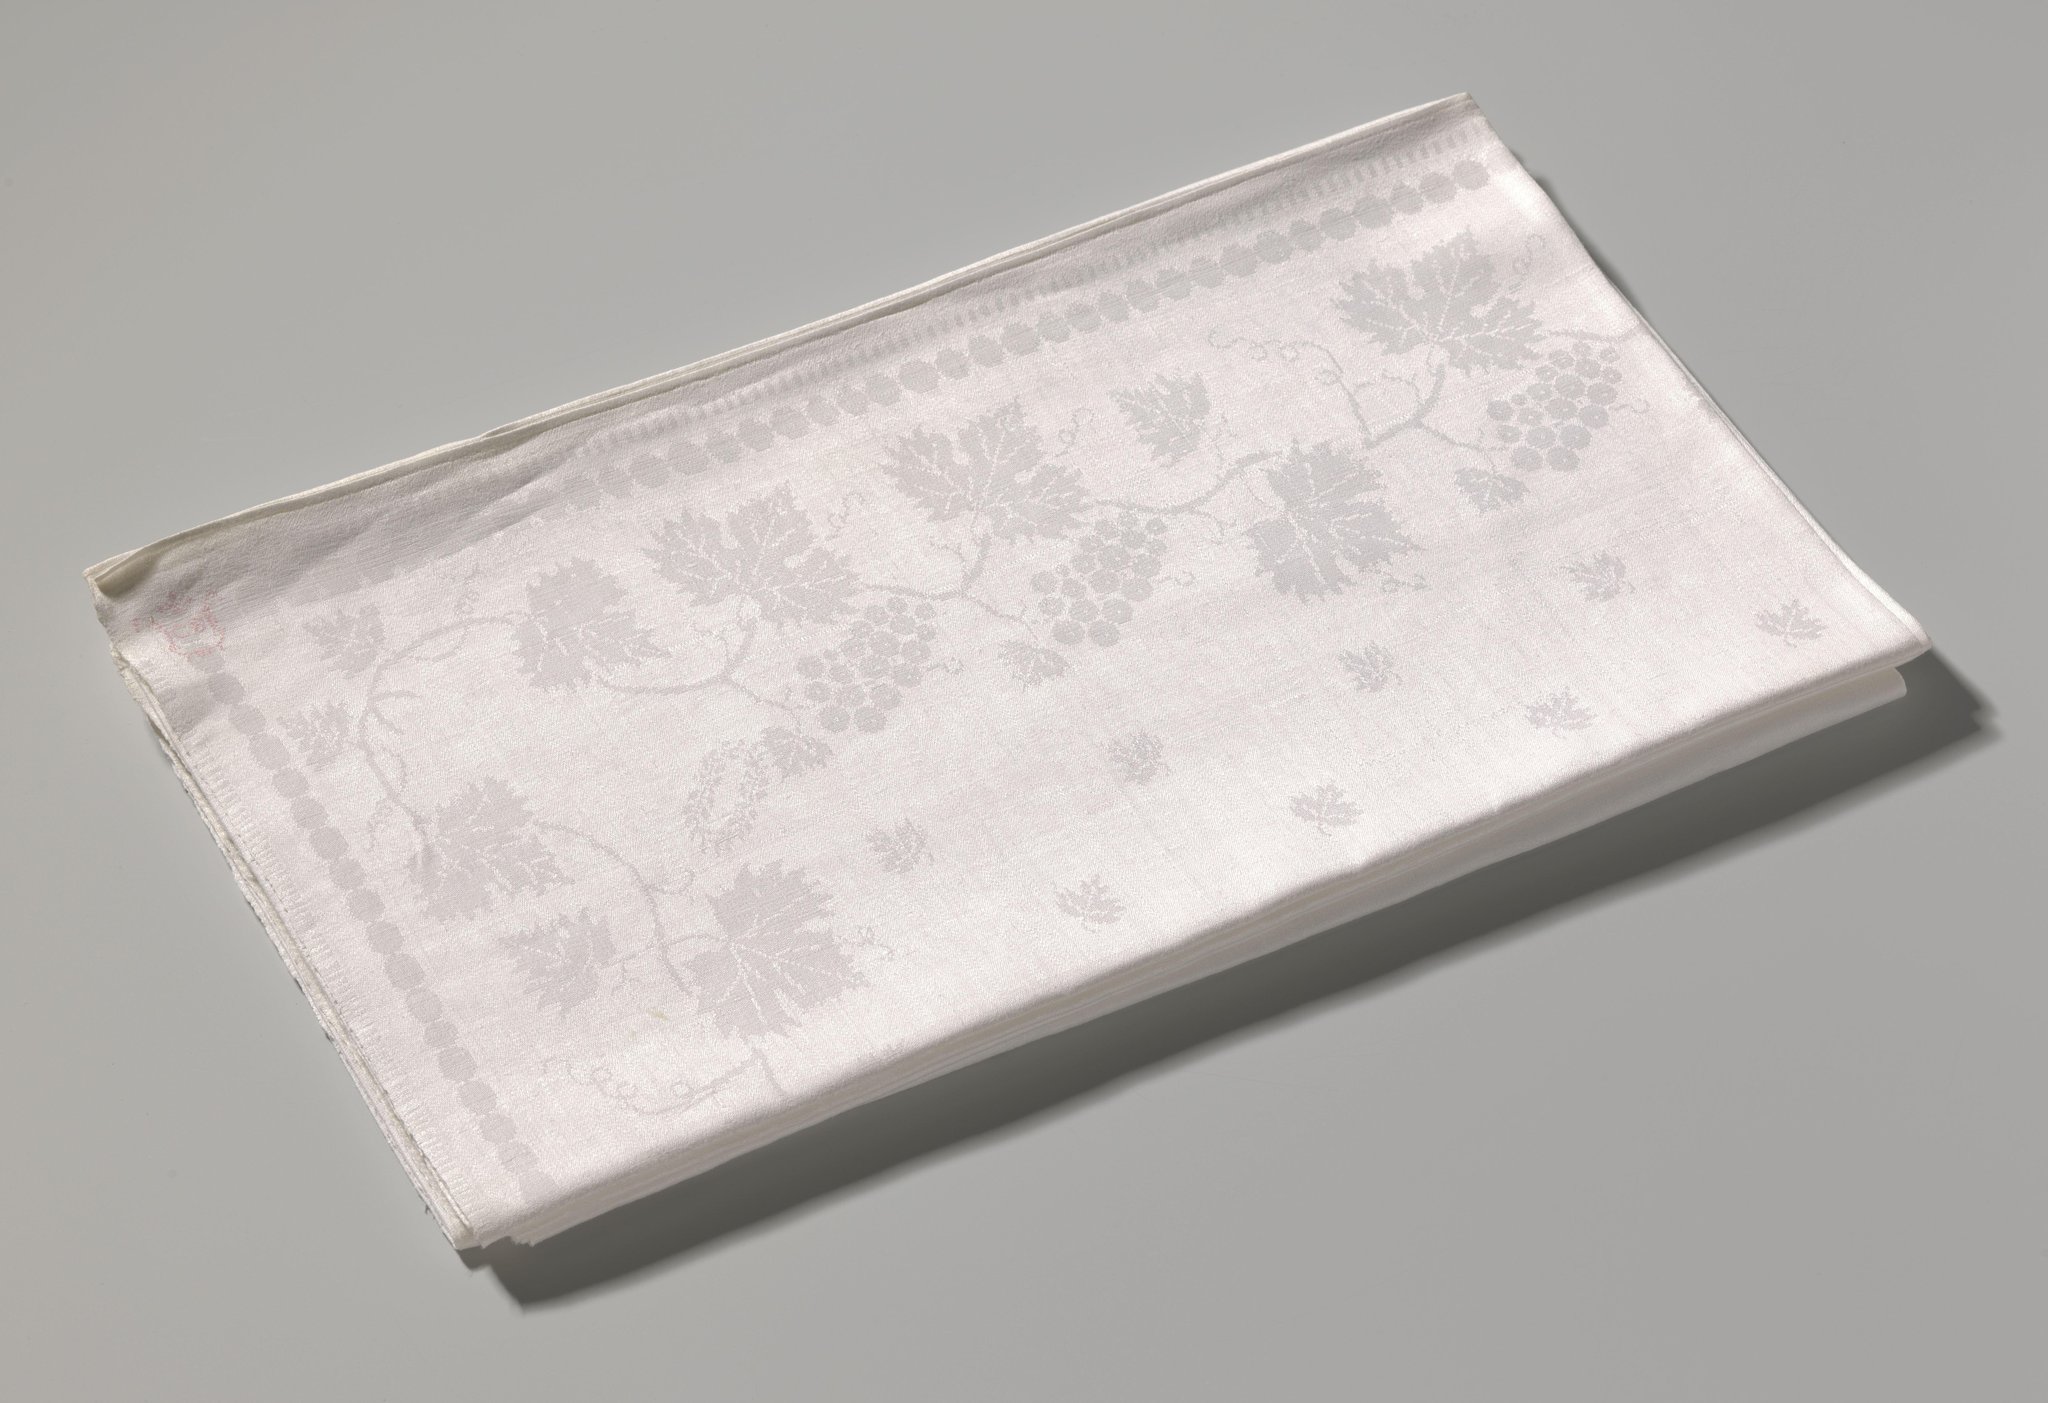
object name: tablecloth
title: Tafellaken van wit linnendamast met druivenpatroon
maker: Anonymous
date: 1800-1900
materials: linen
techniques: damask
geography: netherlands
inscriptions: mark: ‘gekroonde letters "CB" omringd door voluten’, number: ‘915’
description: Wit linnendamasten tafellaken met druivenpatroon. Merk gekroonde letters "CB" omringd door voluten.